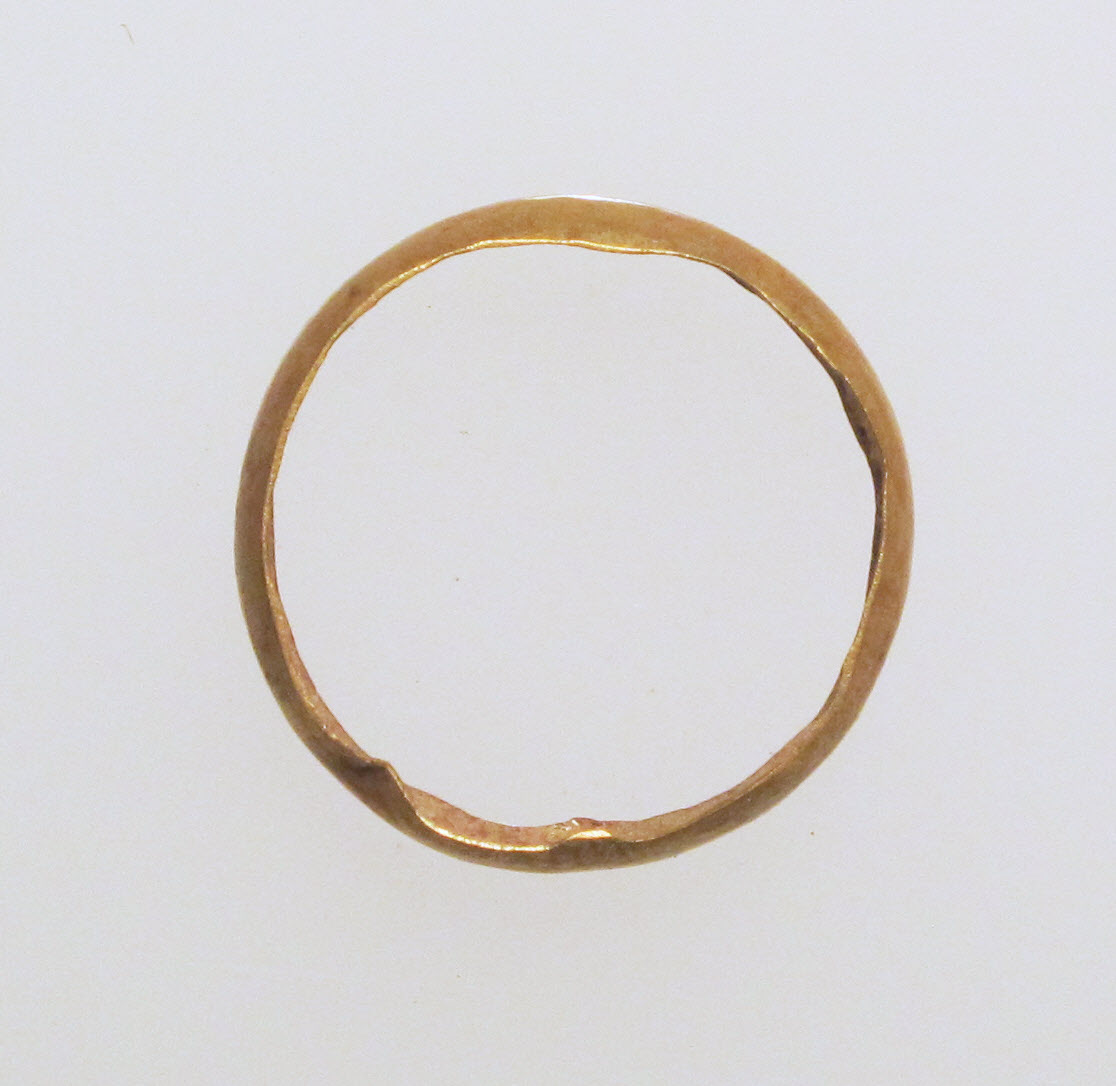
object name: ring with hollow hoop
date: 7000 BCE-330 CE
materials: gold